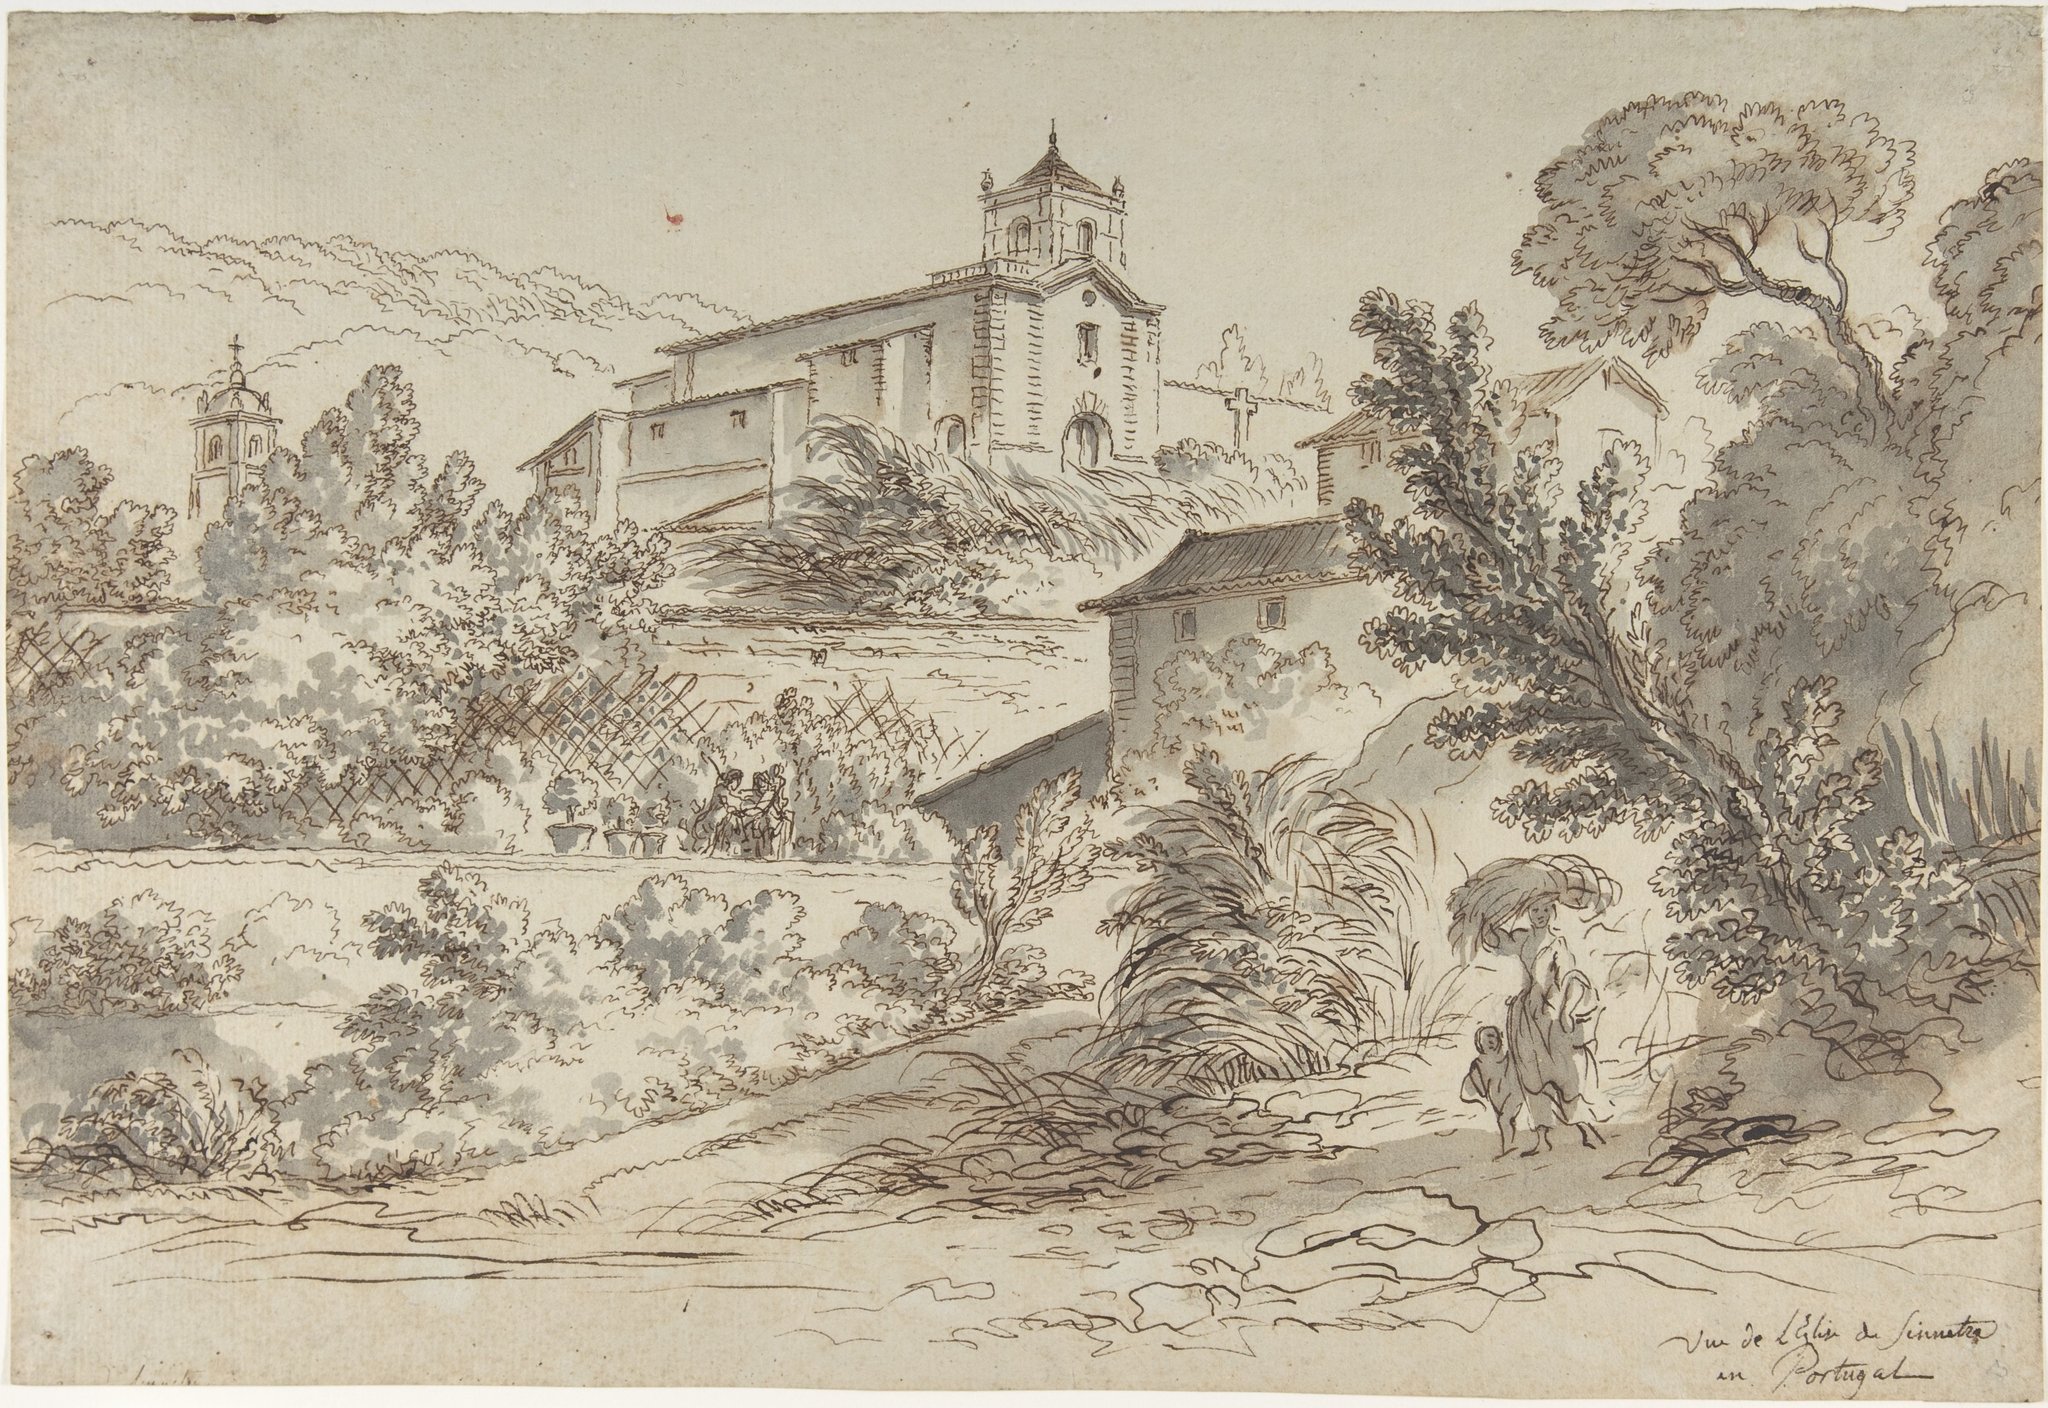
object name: drawing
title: The Church of São Martinho in Sintra, Portugal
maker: pierre lélu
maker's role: artist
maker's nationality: french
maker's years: 1741-1810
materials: graphite, ink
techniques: brush, pen, wash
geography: france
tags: houses,churches,trees